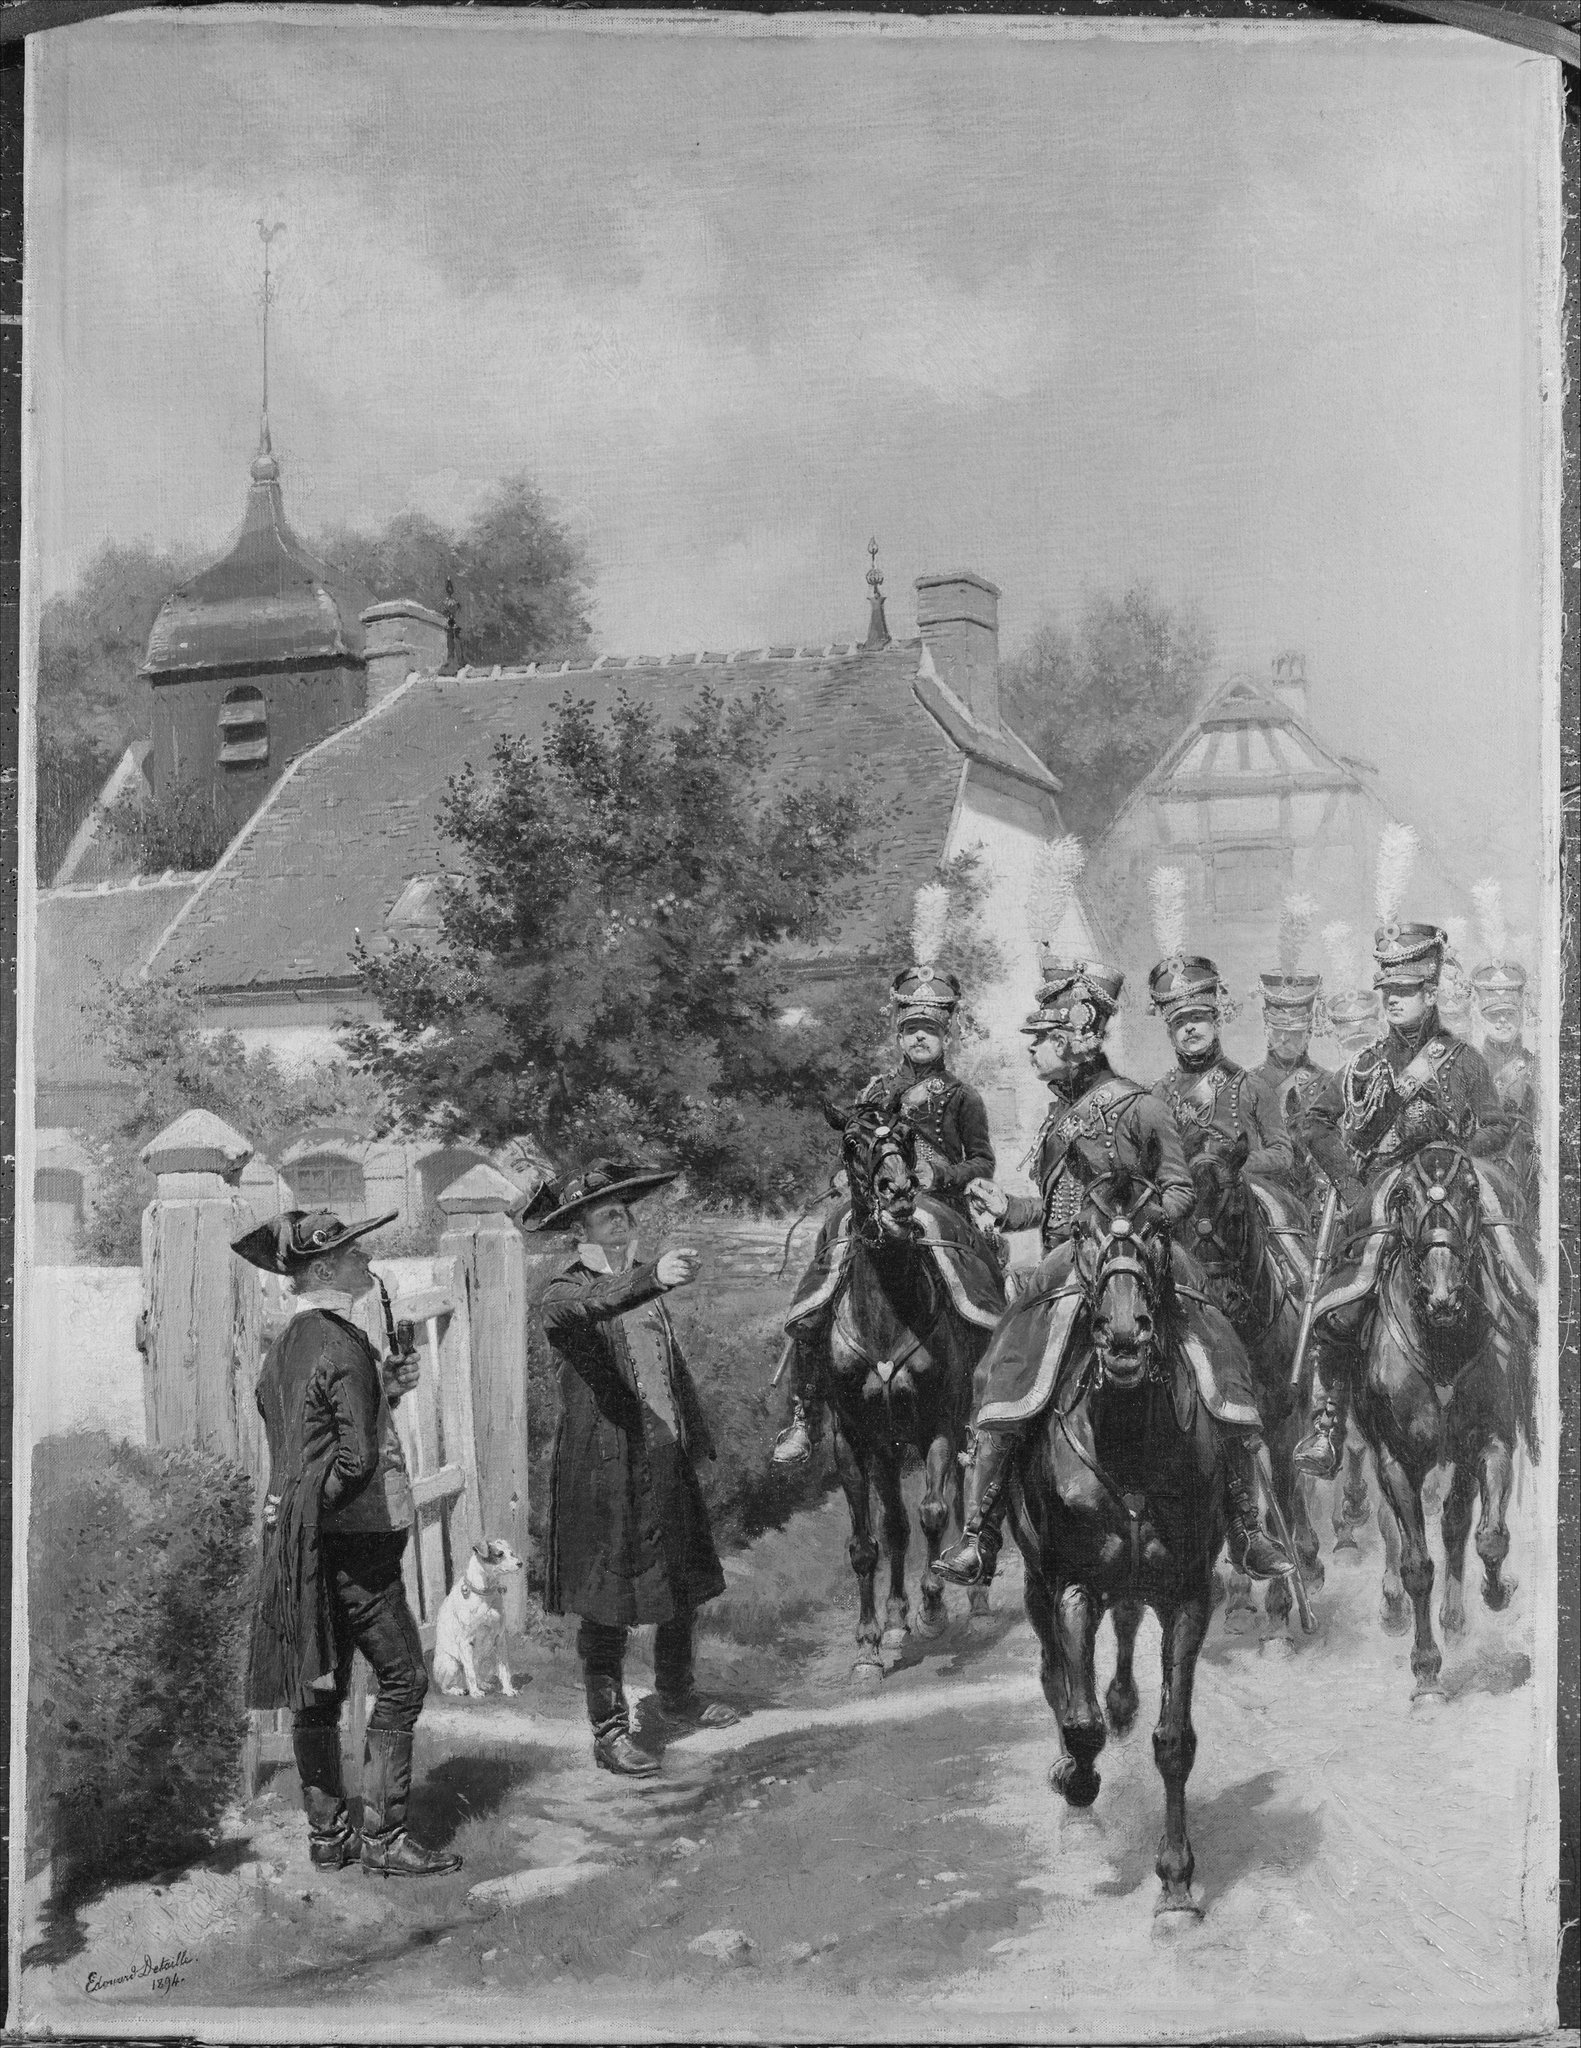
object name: book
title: Vita Sanctae Catherinae Senensis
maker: nicolaus burgensius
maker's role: author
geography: italy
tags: houses,soldiers,men,horses,trees